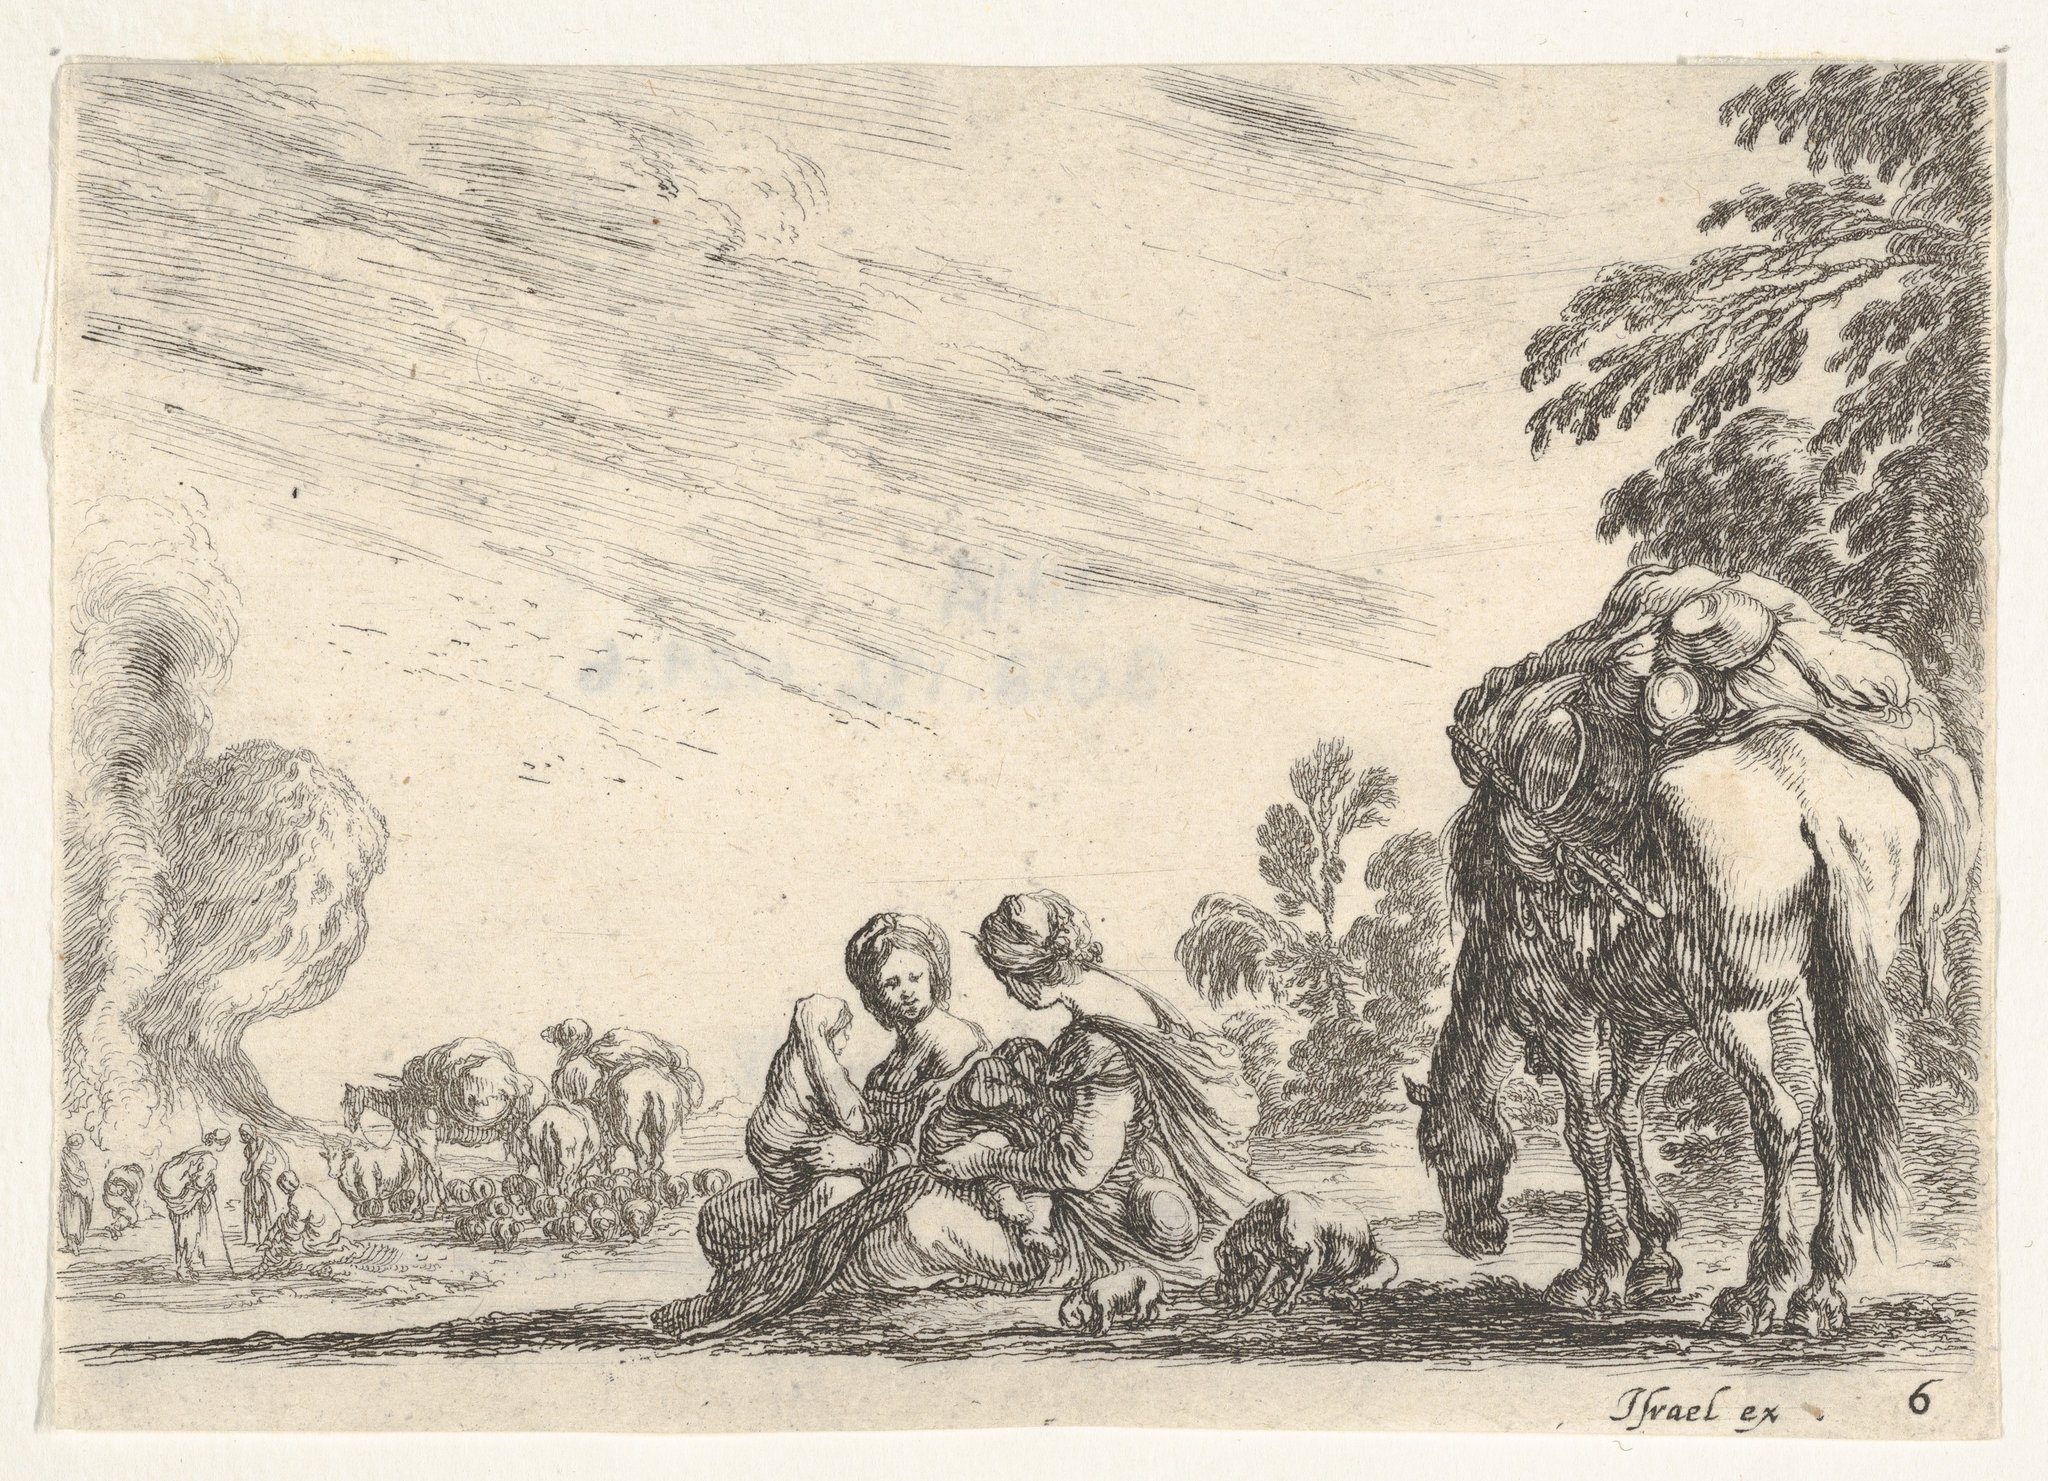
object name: print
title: Plate 6: two women, one nursing a child, seated next to a dog and a horse carrying a pack, horses and figures to left in the background, from "Various Figures" (Agréable diversité de figures)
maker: stefano della bella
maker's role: artist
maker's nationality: italian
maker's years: 1610-1664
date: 1642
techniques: etching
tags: infants,women,dogs,horses